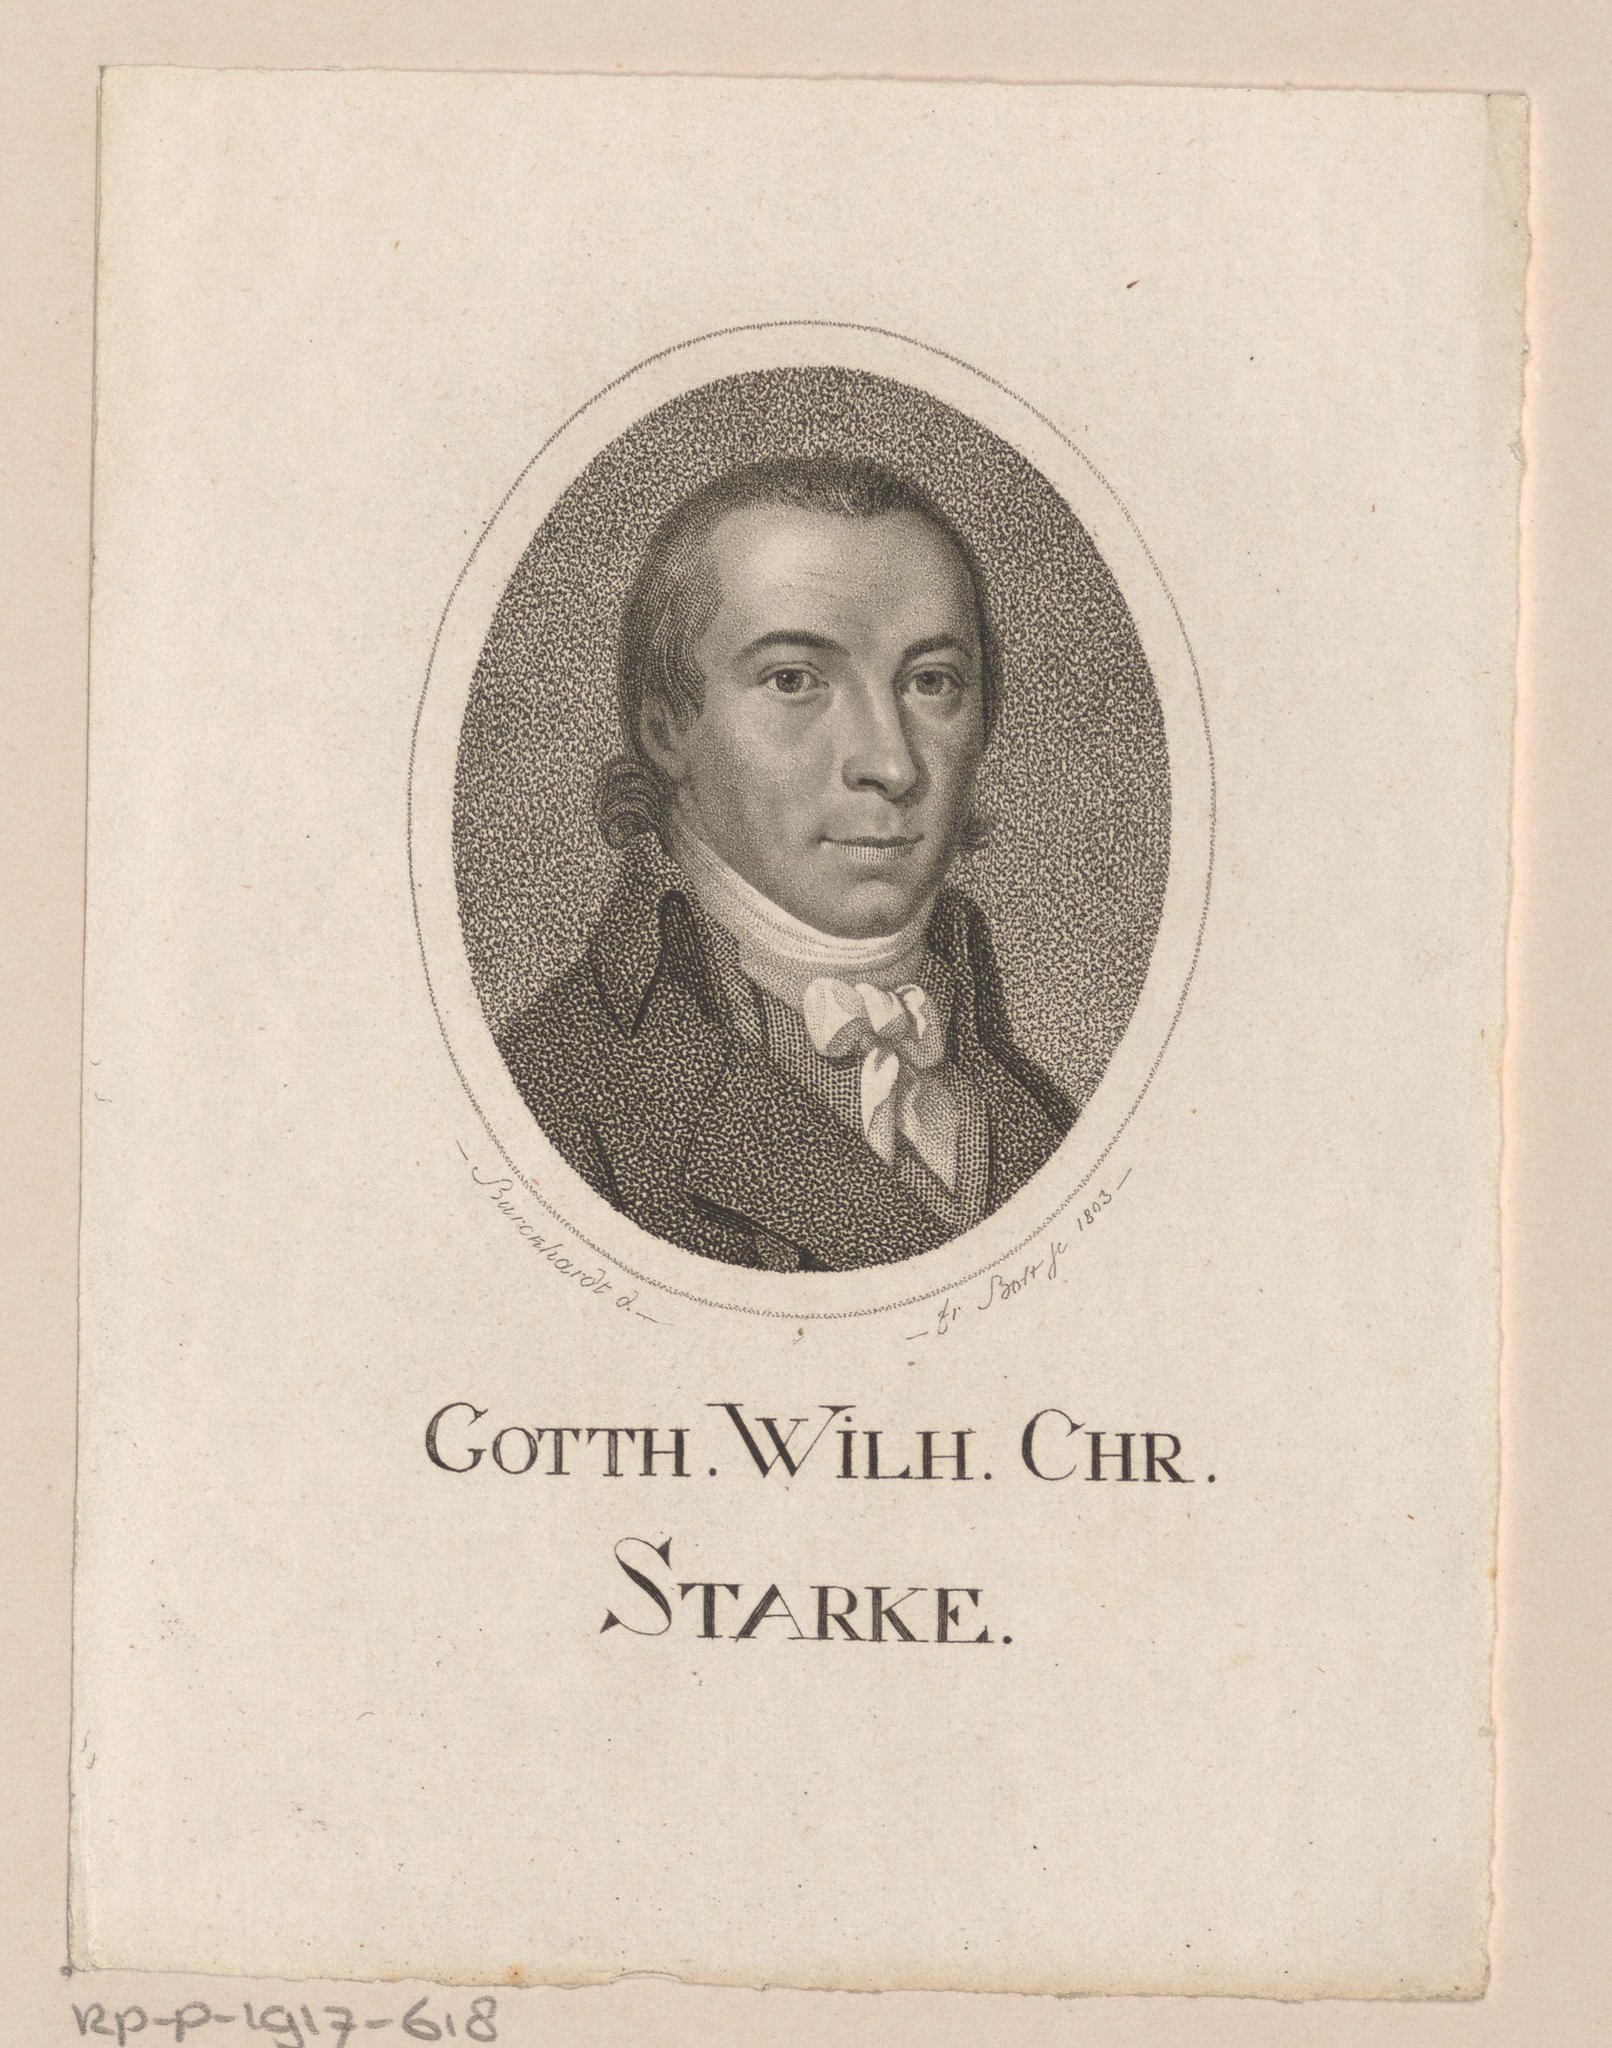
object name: print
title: Portret van Gotthelf Wilhelm Christoph Starke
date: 1803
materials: paper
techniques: etching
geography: berlin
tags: theologian, historical persons, portrait of a writer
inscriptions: collector's mark: Lugt 2228